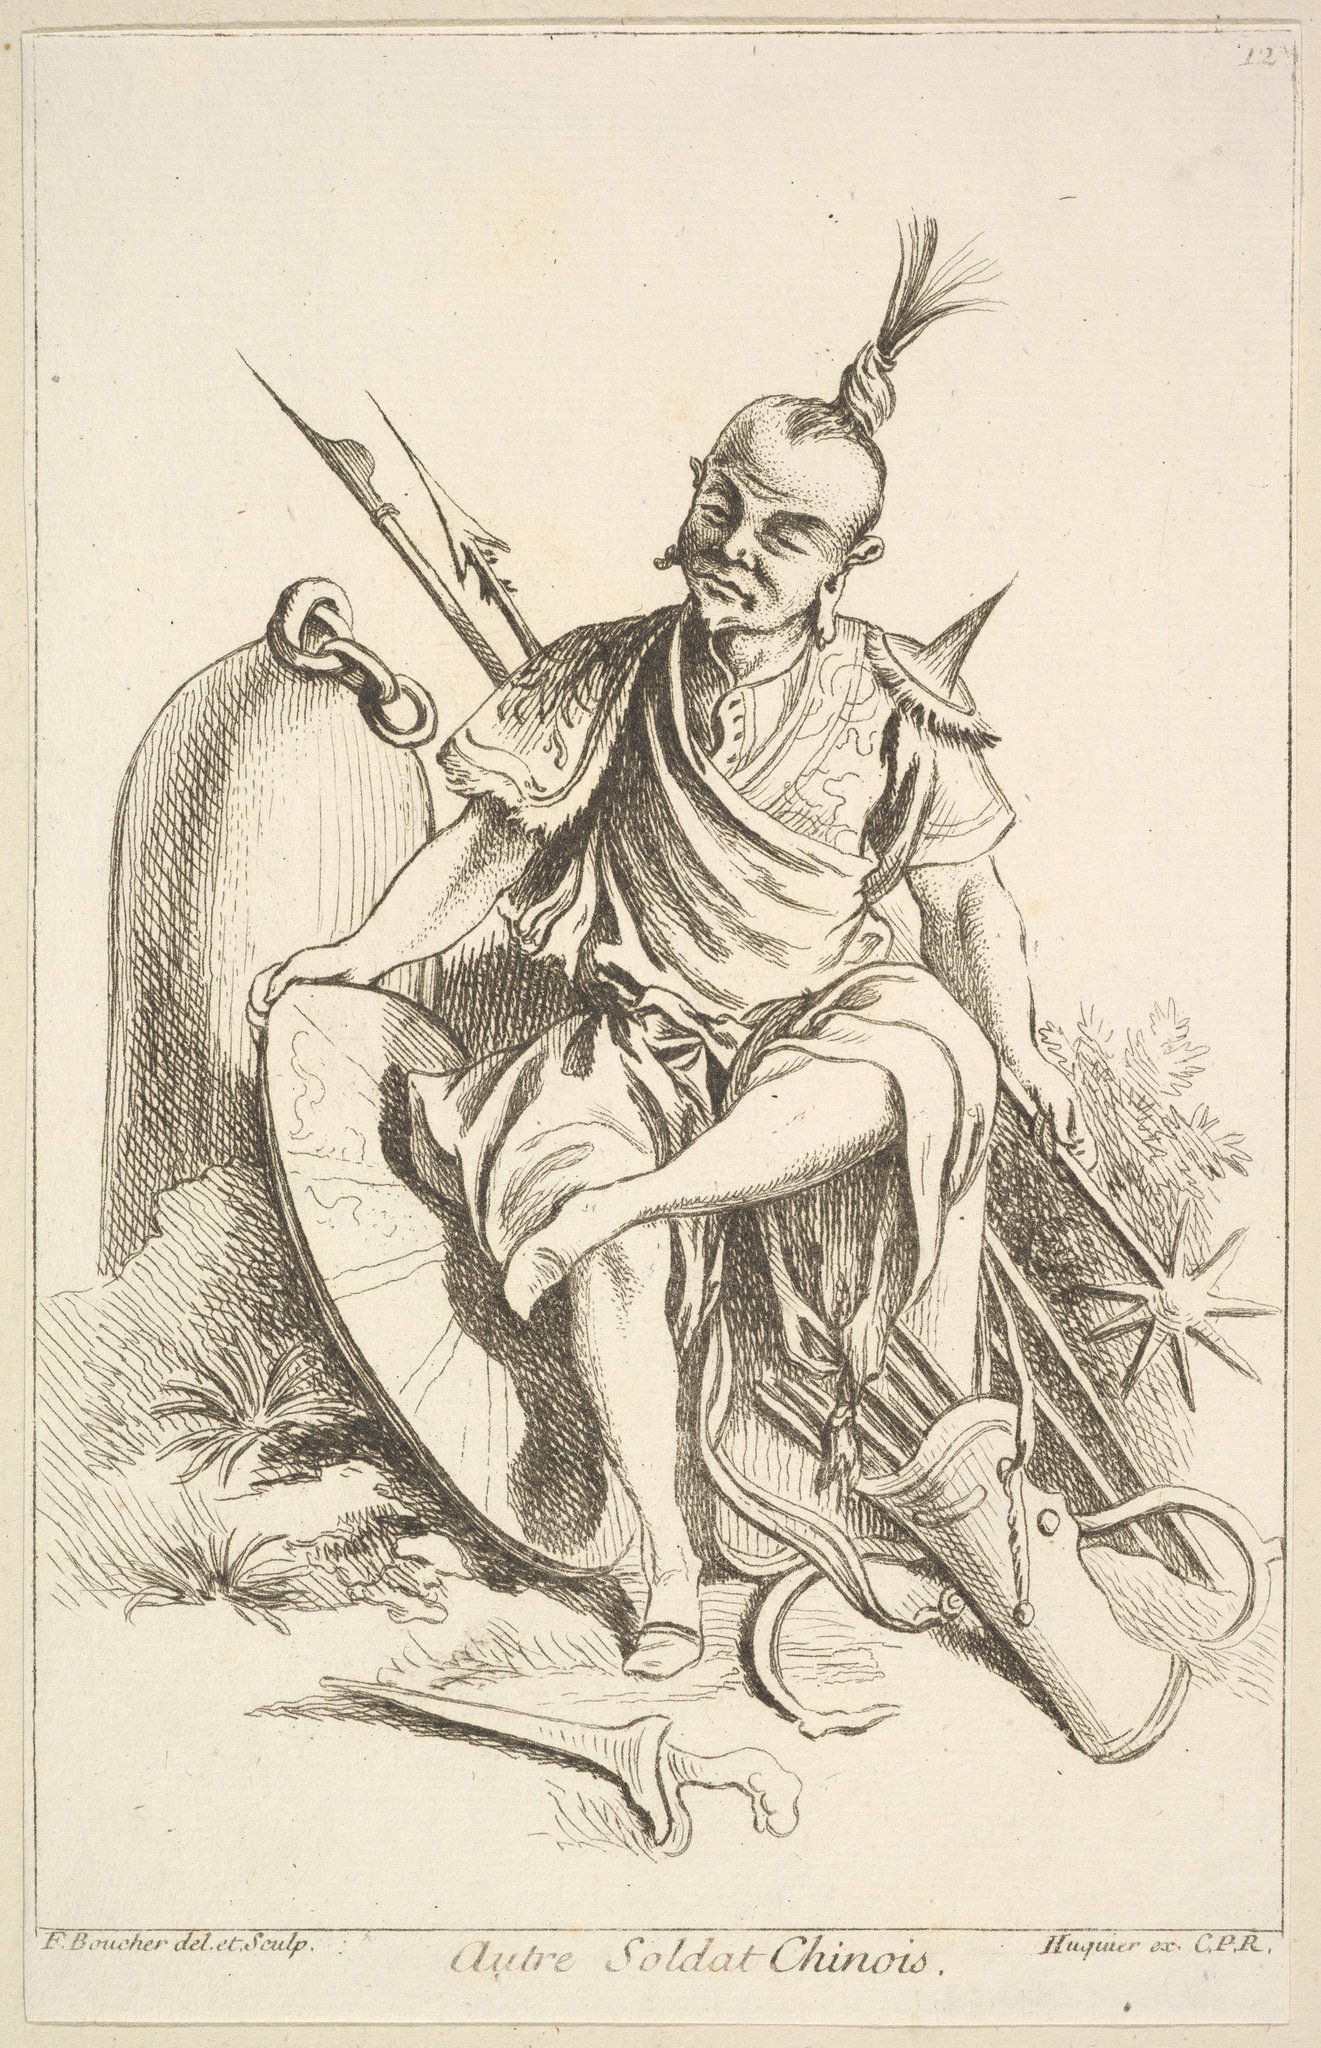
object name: print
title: Other Chinese Soldier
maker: françois boucher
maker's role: artist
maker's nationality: french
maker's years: 1703-1770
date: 1738-1745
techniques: etching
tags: soldiers,arrows,shields,men